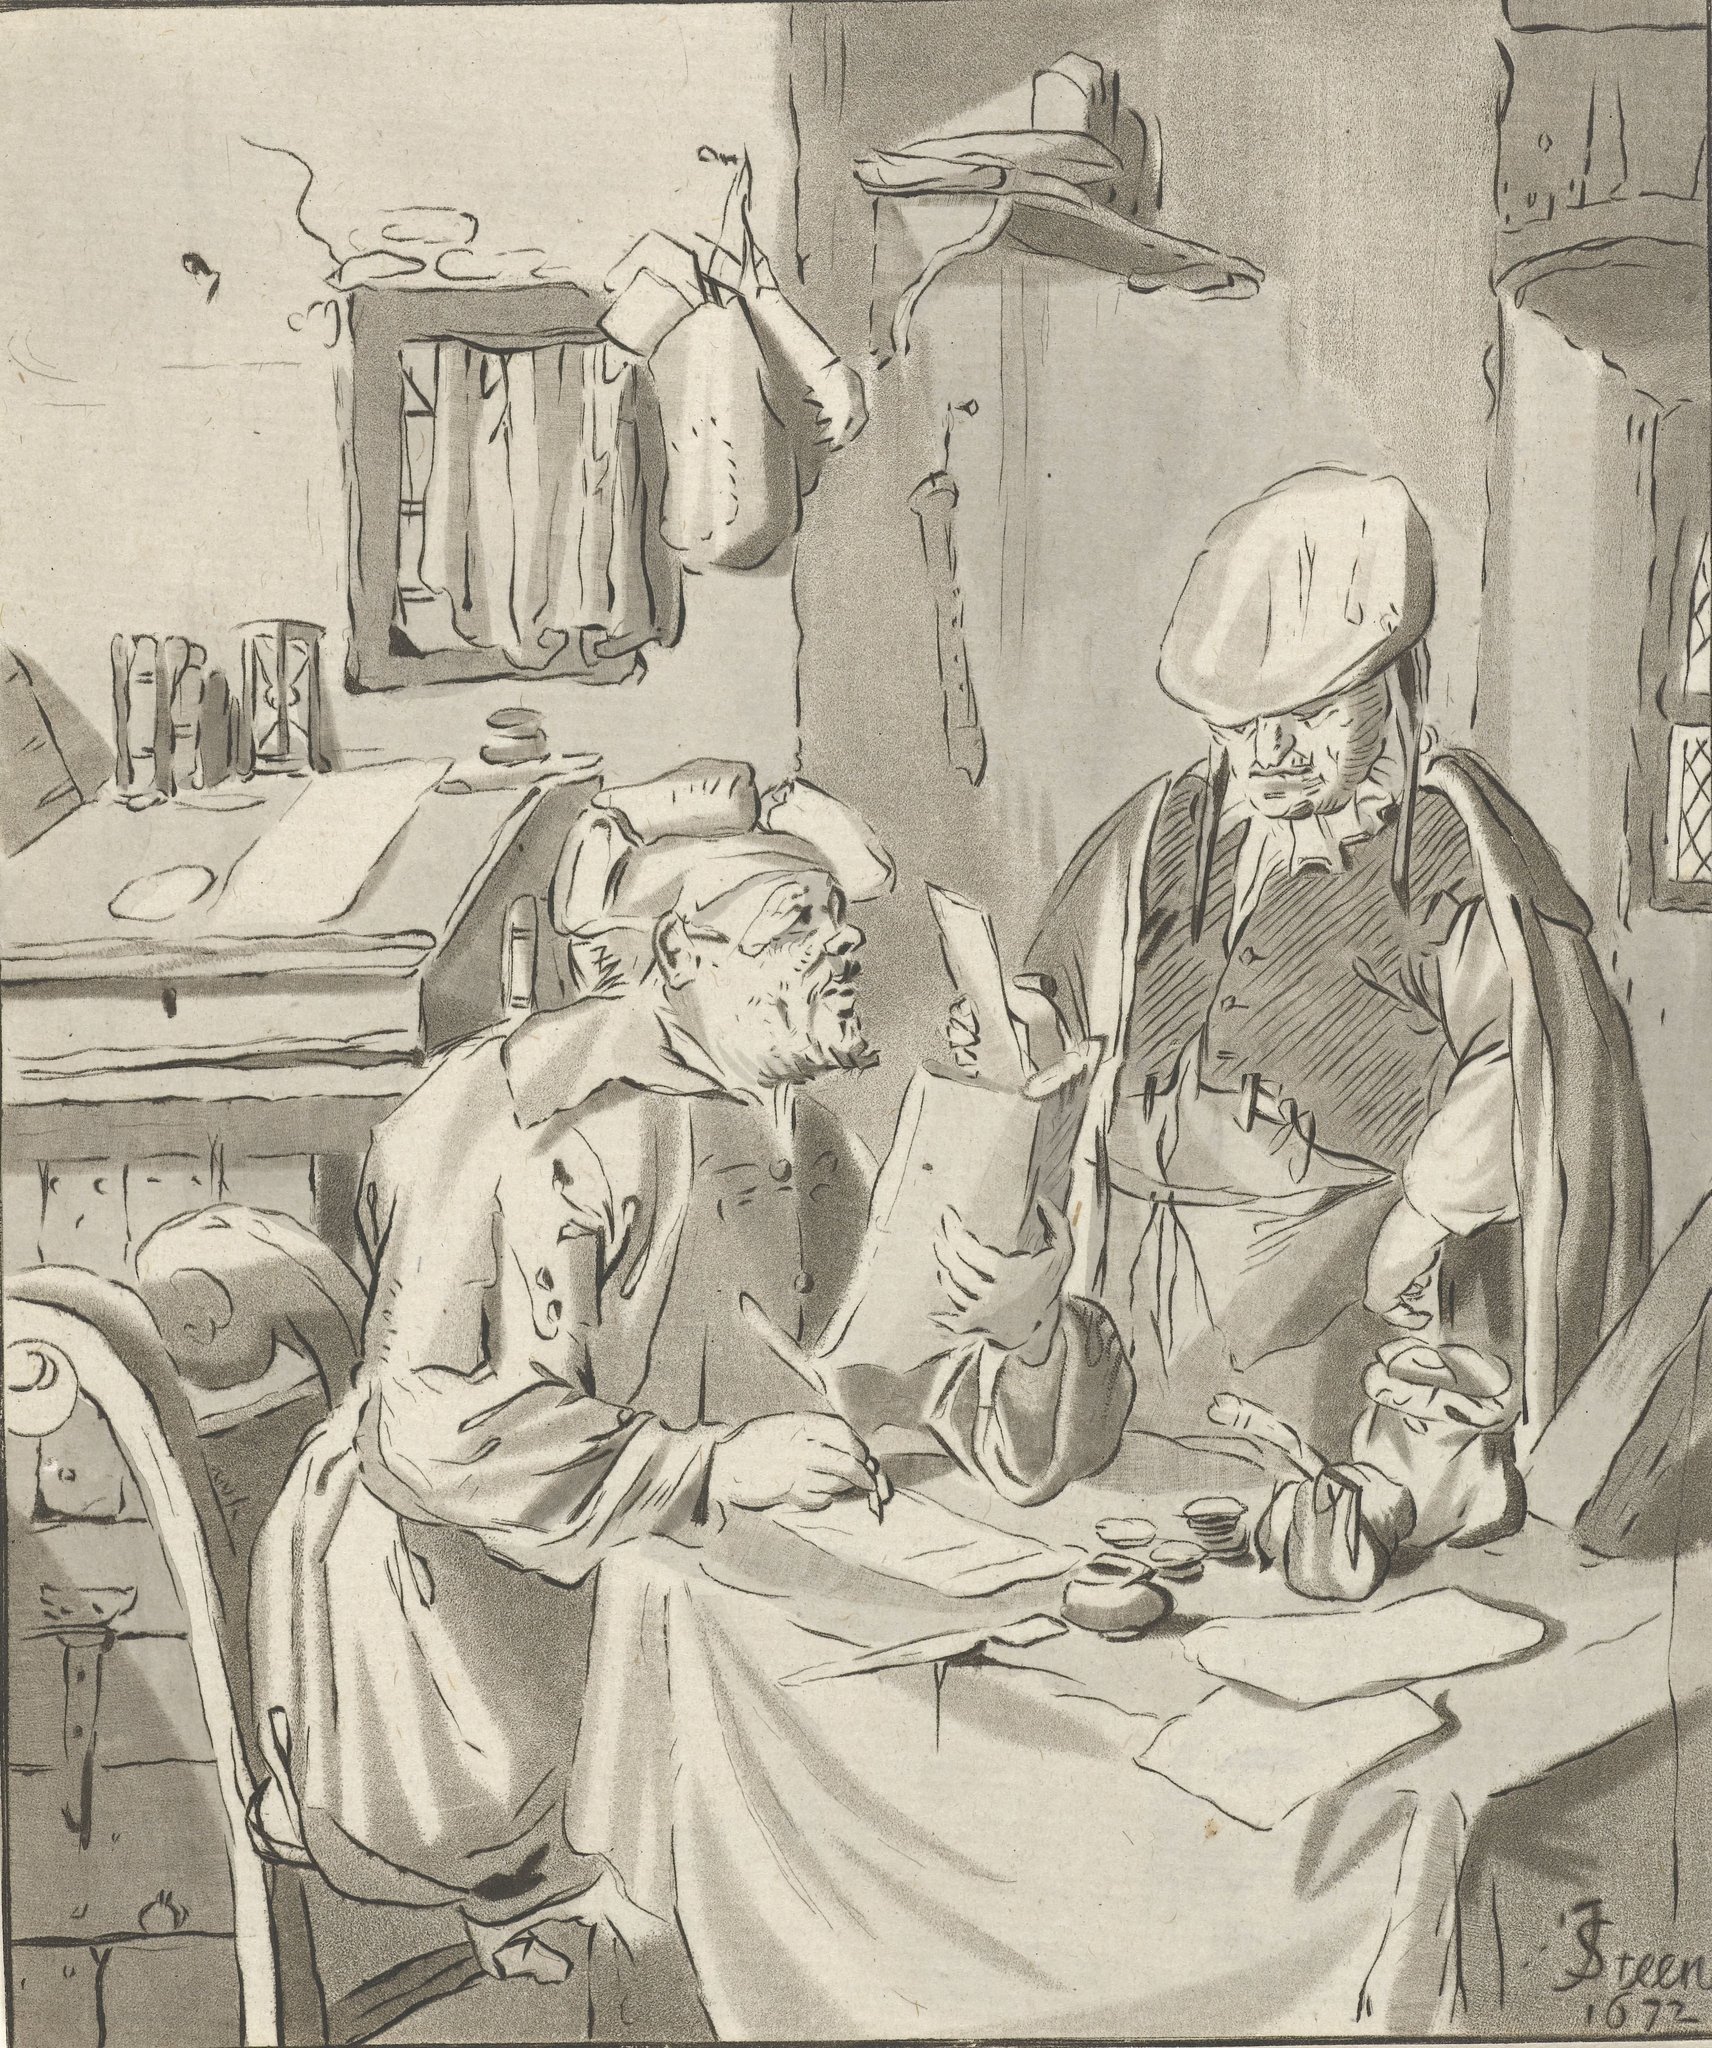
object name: print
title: Schrijver van een brief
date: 1777-1786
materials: paper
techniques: etching, hand coloring, roulette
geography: amsterdam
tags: sitting figure, writing tools, letter, envelope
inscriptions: collector's mark: Lugt 240, inscription: ‘J. Steen 1672 del. C. Pl. v. Amstel direx’, collector's mark: Lugt 2725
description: Een man, zittend aan een tafel, schrijft een brief. Naast hem staat een man met een brief in de hand.